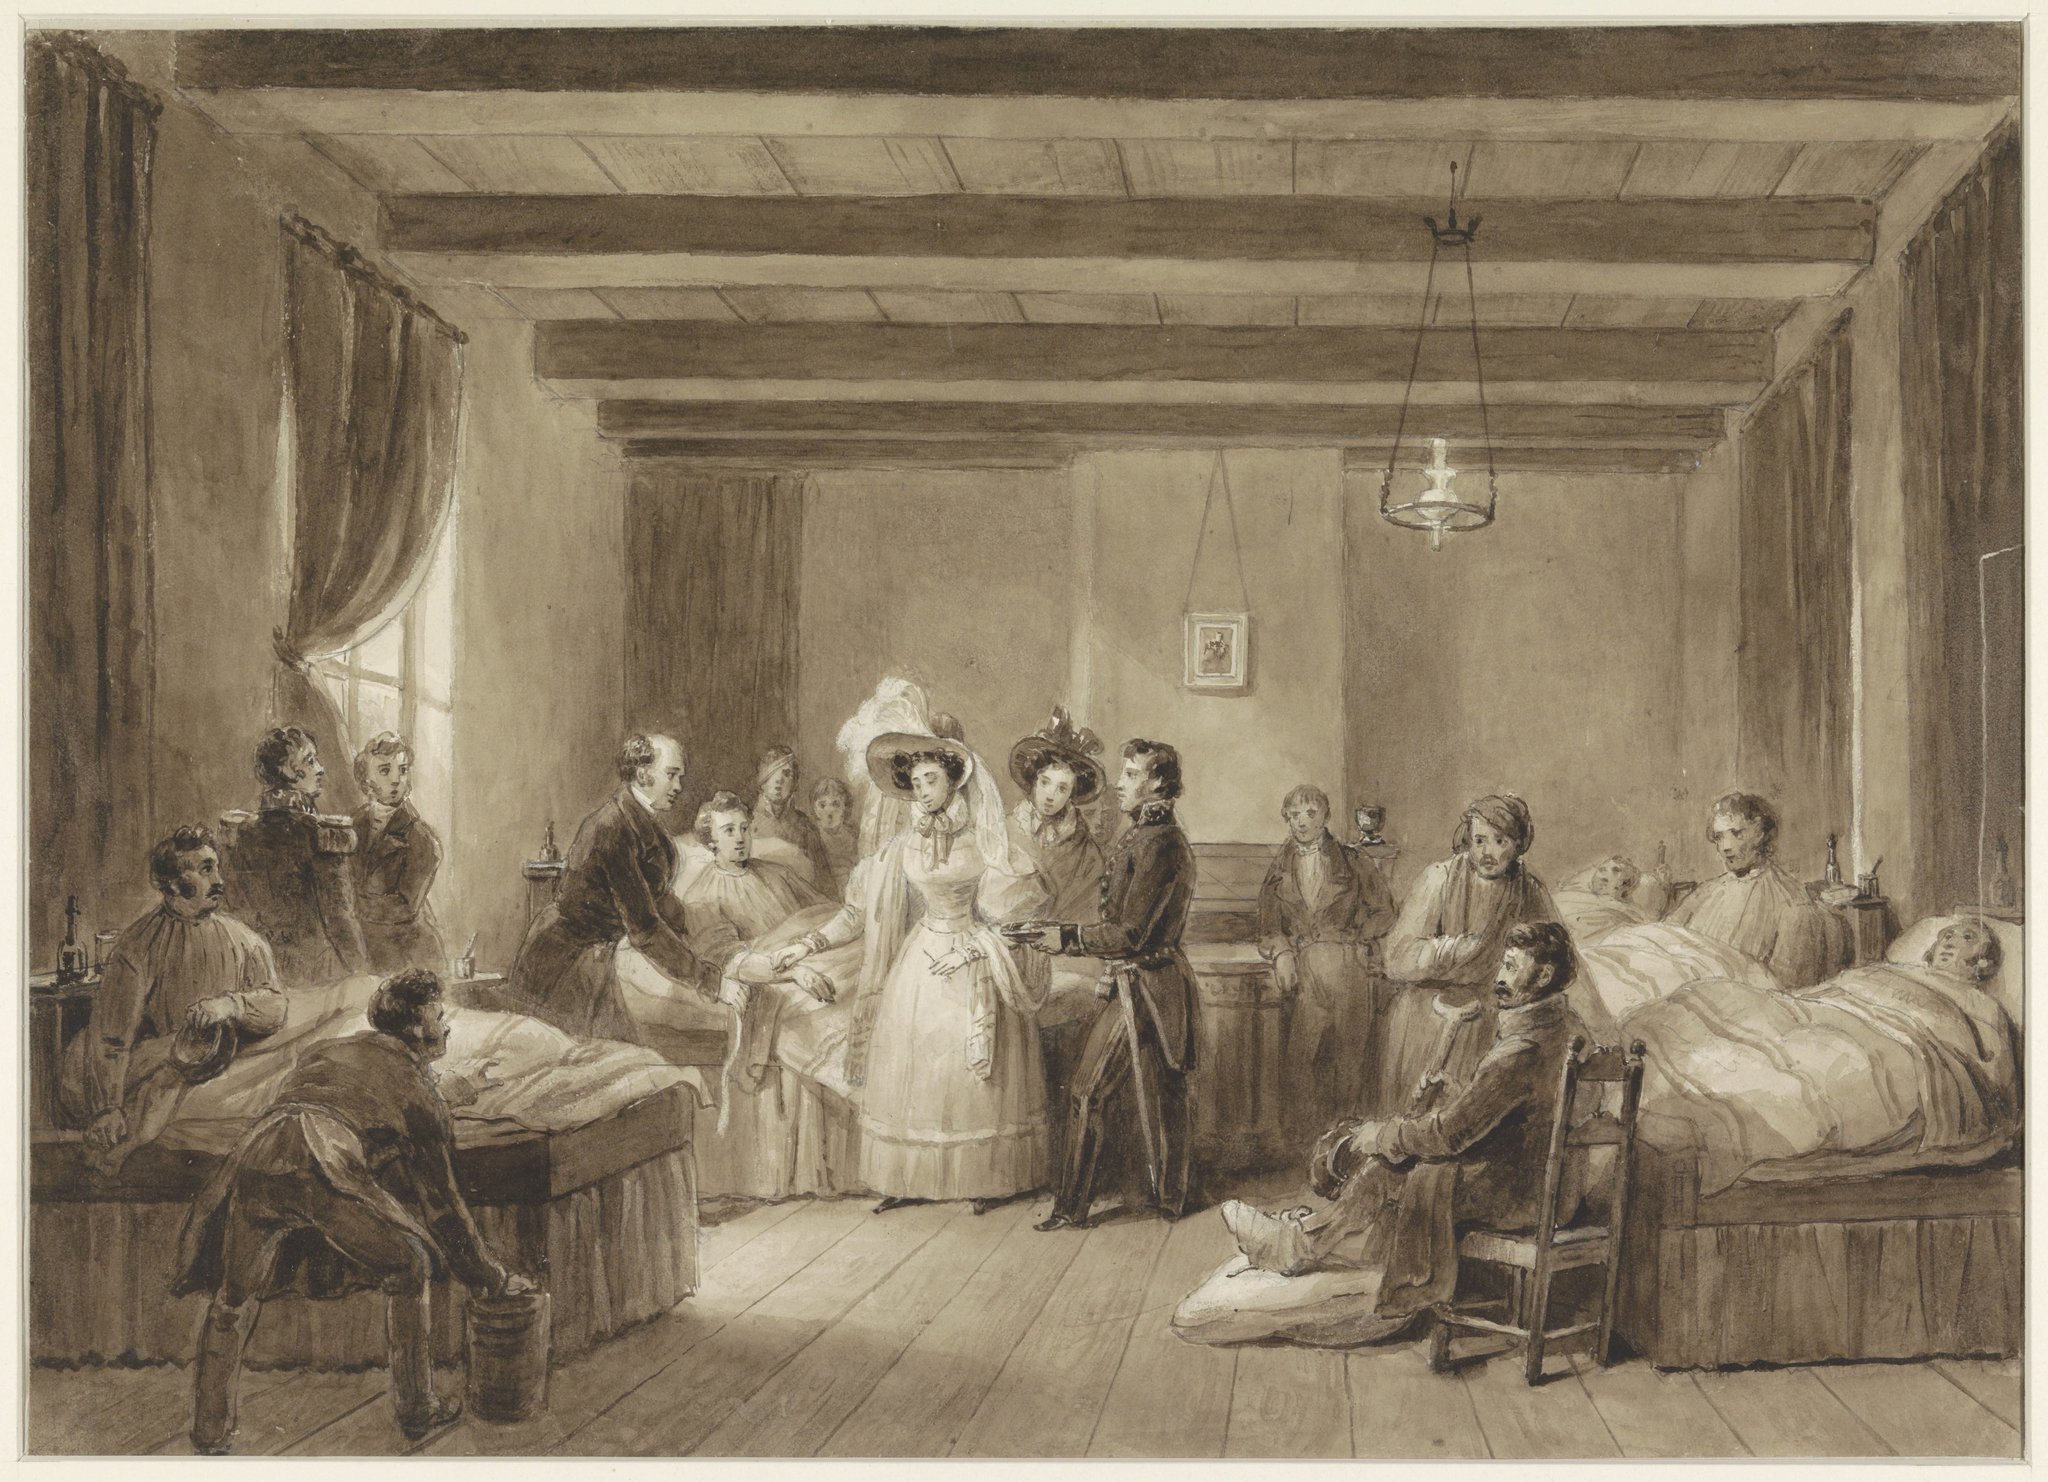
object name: drawing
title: Prinses van Oranje bezoekt het soldatenhospitaal te 's-Gravenhage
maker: jacob joseph eeckhout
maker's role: draughtsman, print maker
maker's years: 1793-1861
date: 1803-1861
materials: paper, pencil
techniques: brush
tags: historical persons, visiting the sick in hospital, the hague